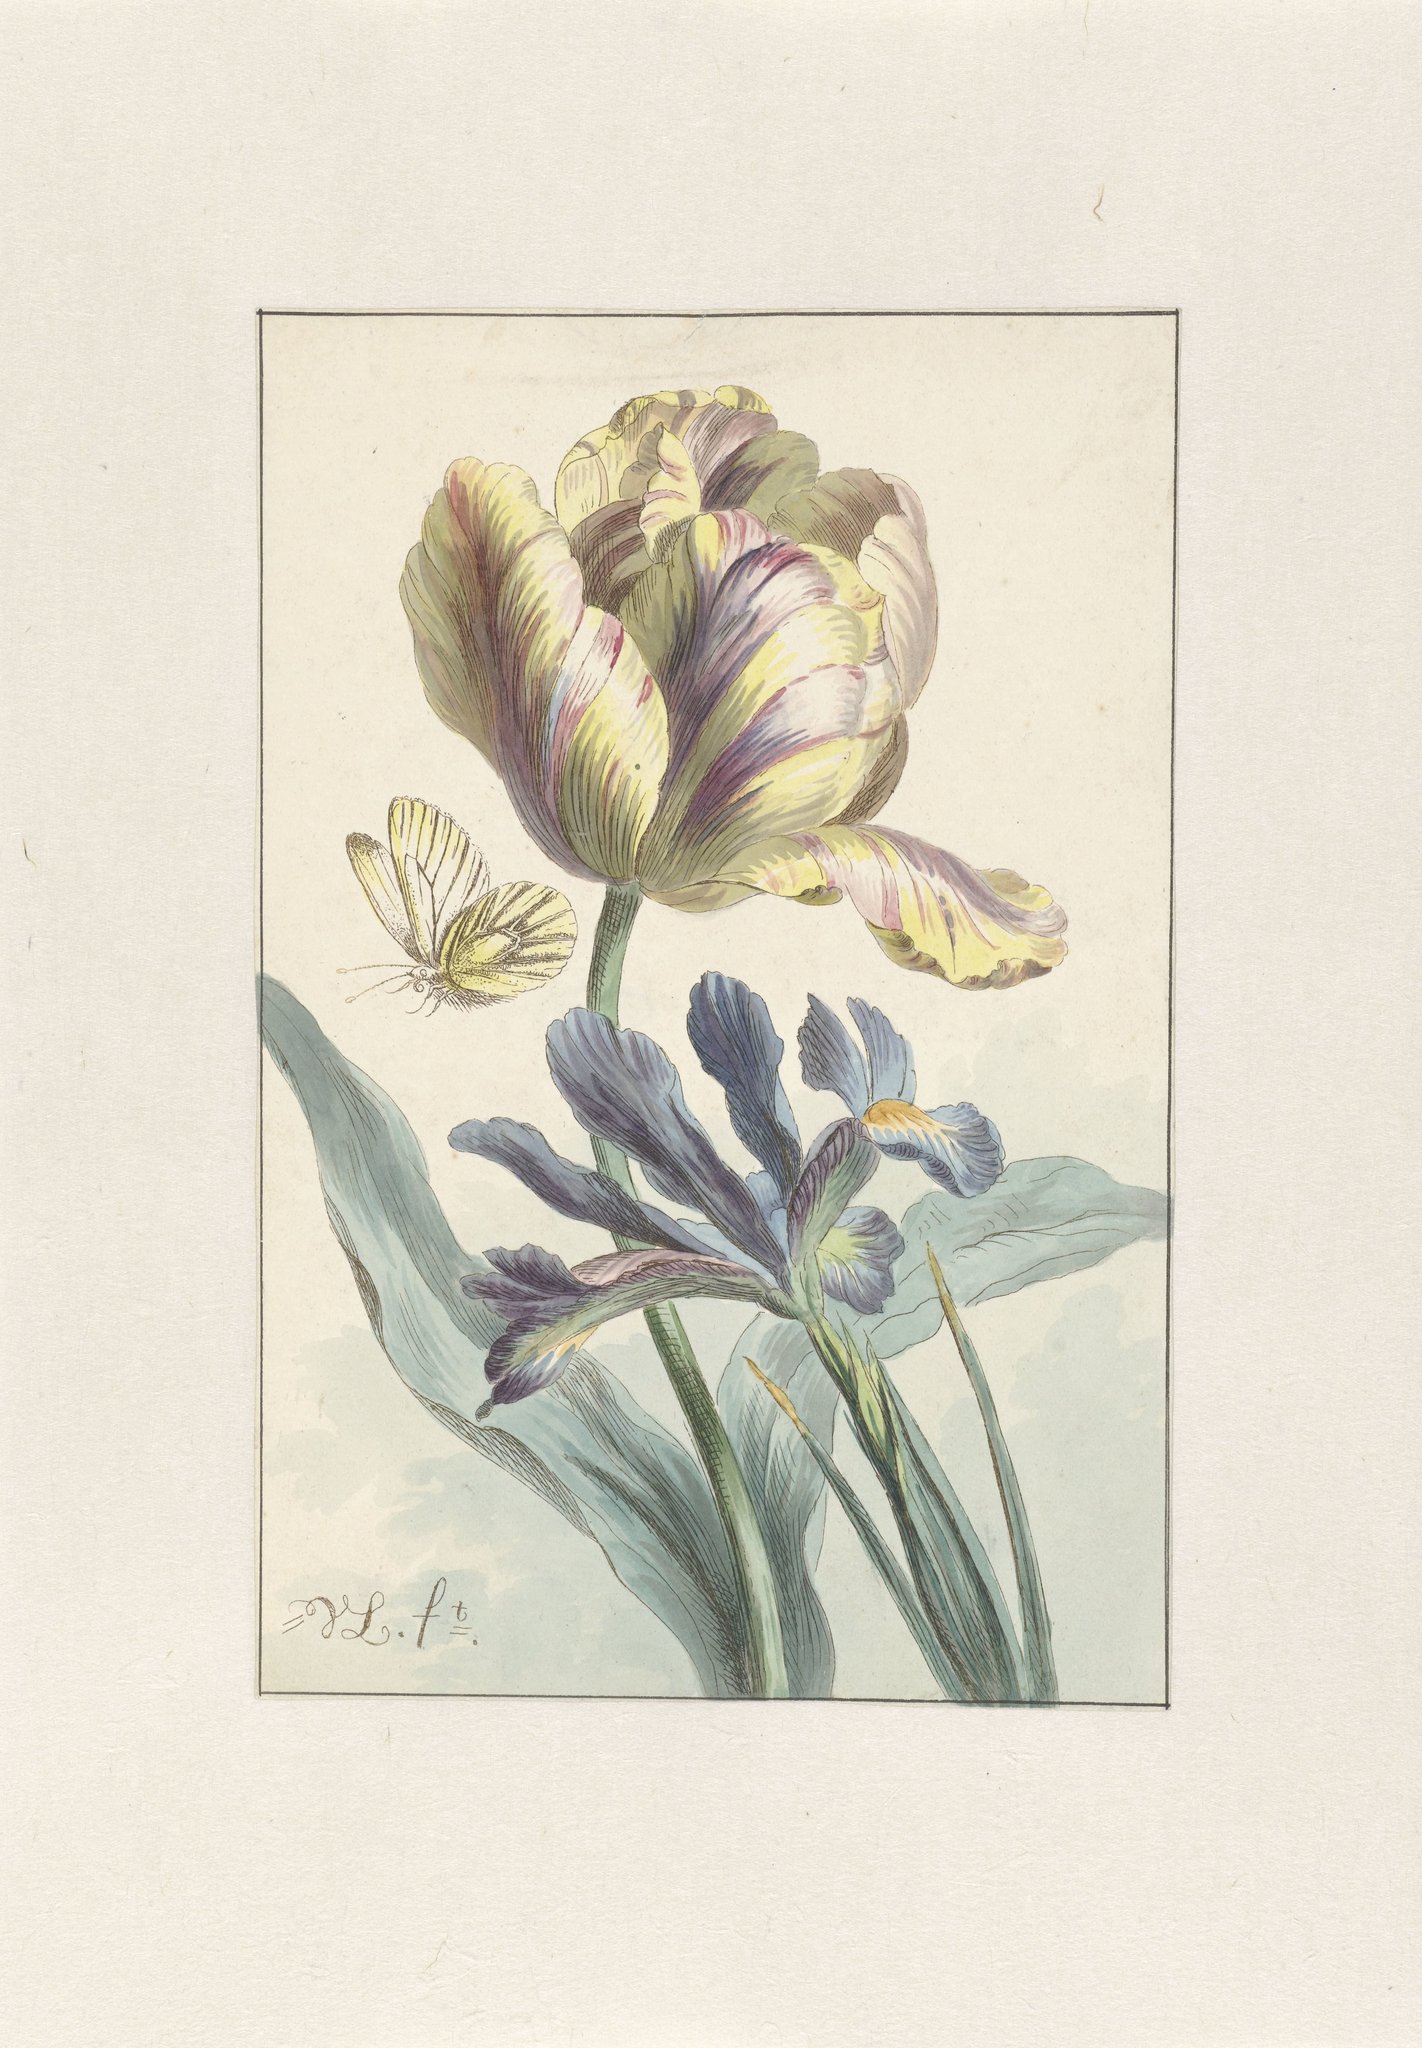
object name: print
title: Tulip and Iris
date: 1804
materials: paper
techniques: etching, hand coloring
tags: insects: butterfly, flowers: tulip, flowers: iris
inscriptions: collector's mark: Lugt 2228, collector's mark: Lugt 2760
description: Bloemenstudie van een tulp en een iris, links vliegt een vlinder. De prent maakt deel uit van een serie prenten met voorstellingen van diverse bloemen.